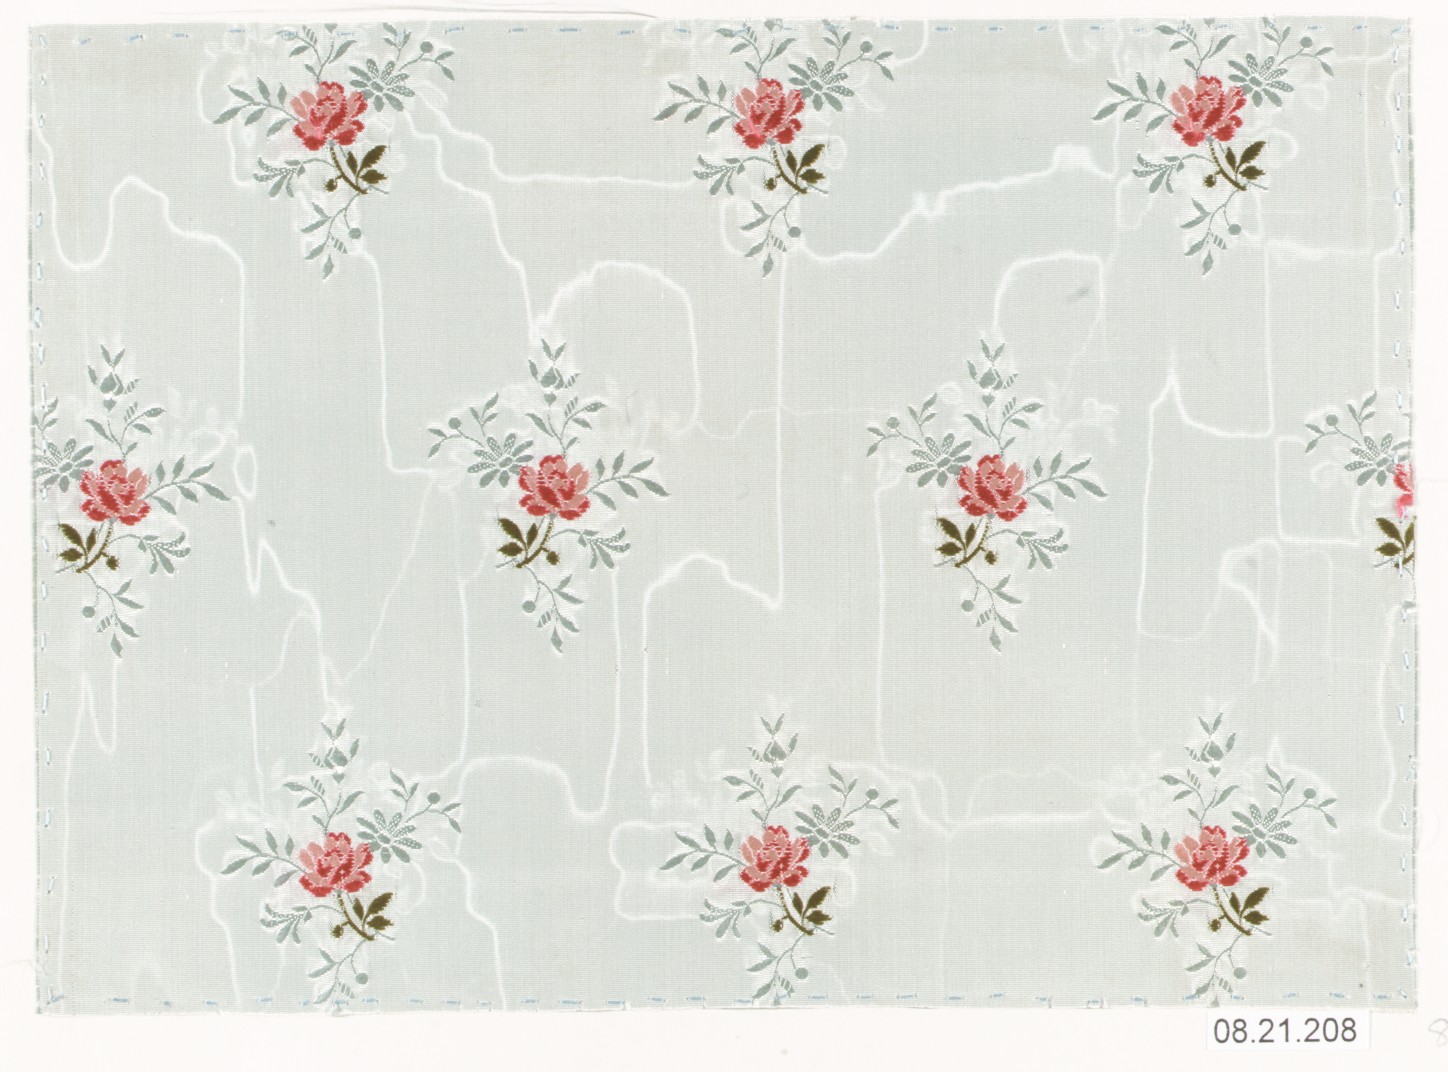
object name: textile sample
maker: Anonymous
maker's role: designer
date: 1900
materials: silk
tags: flowers